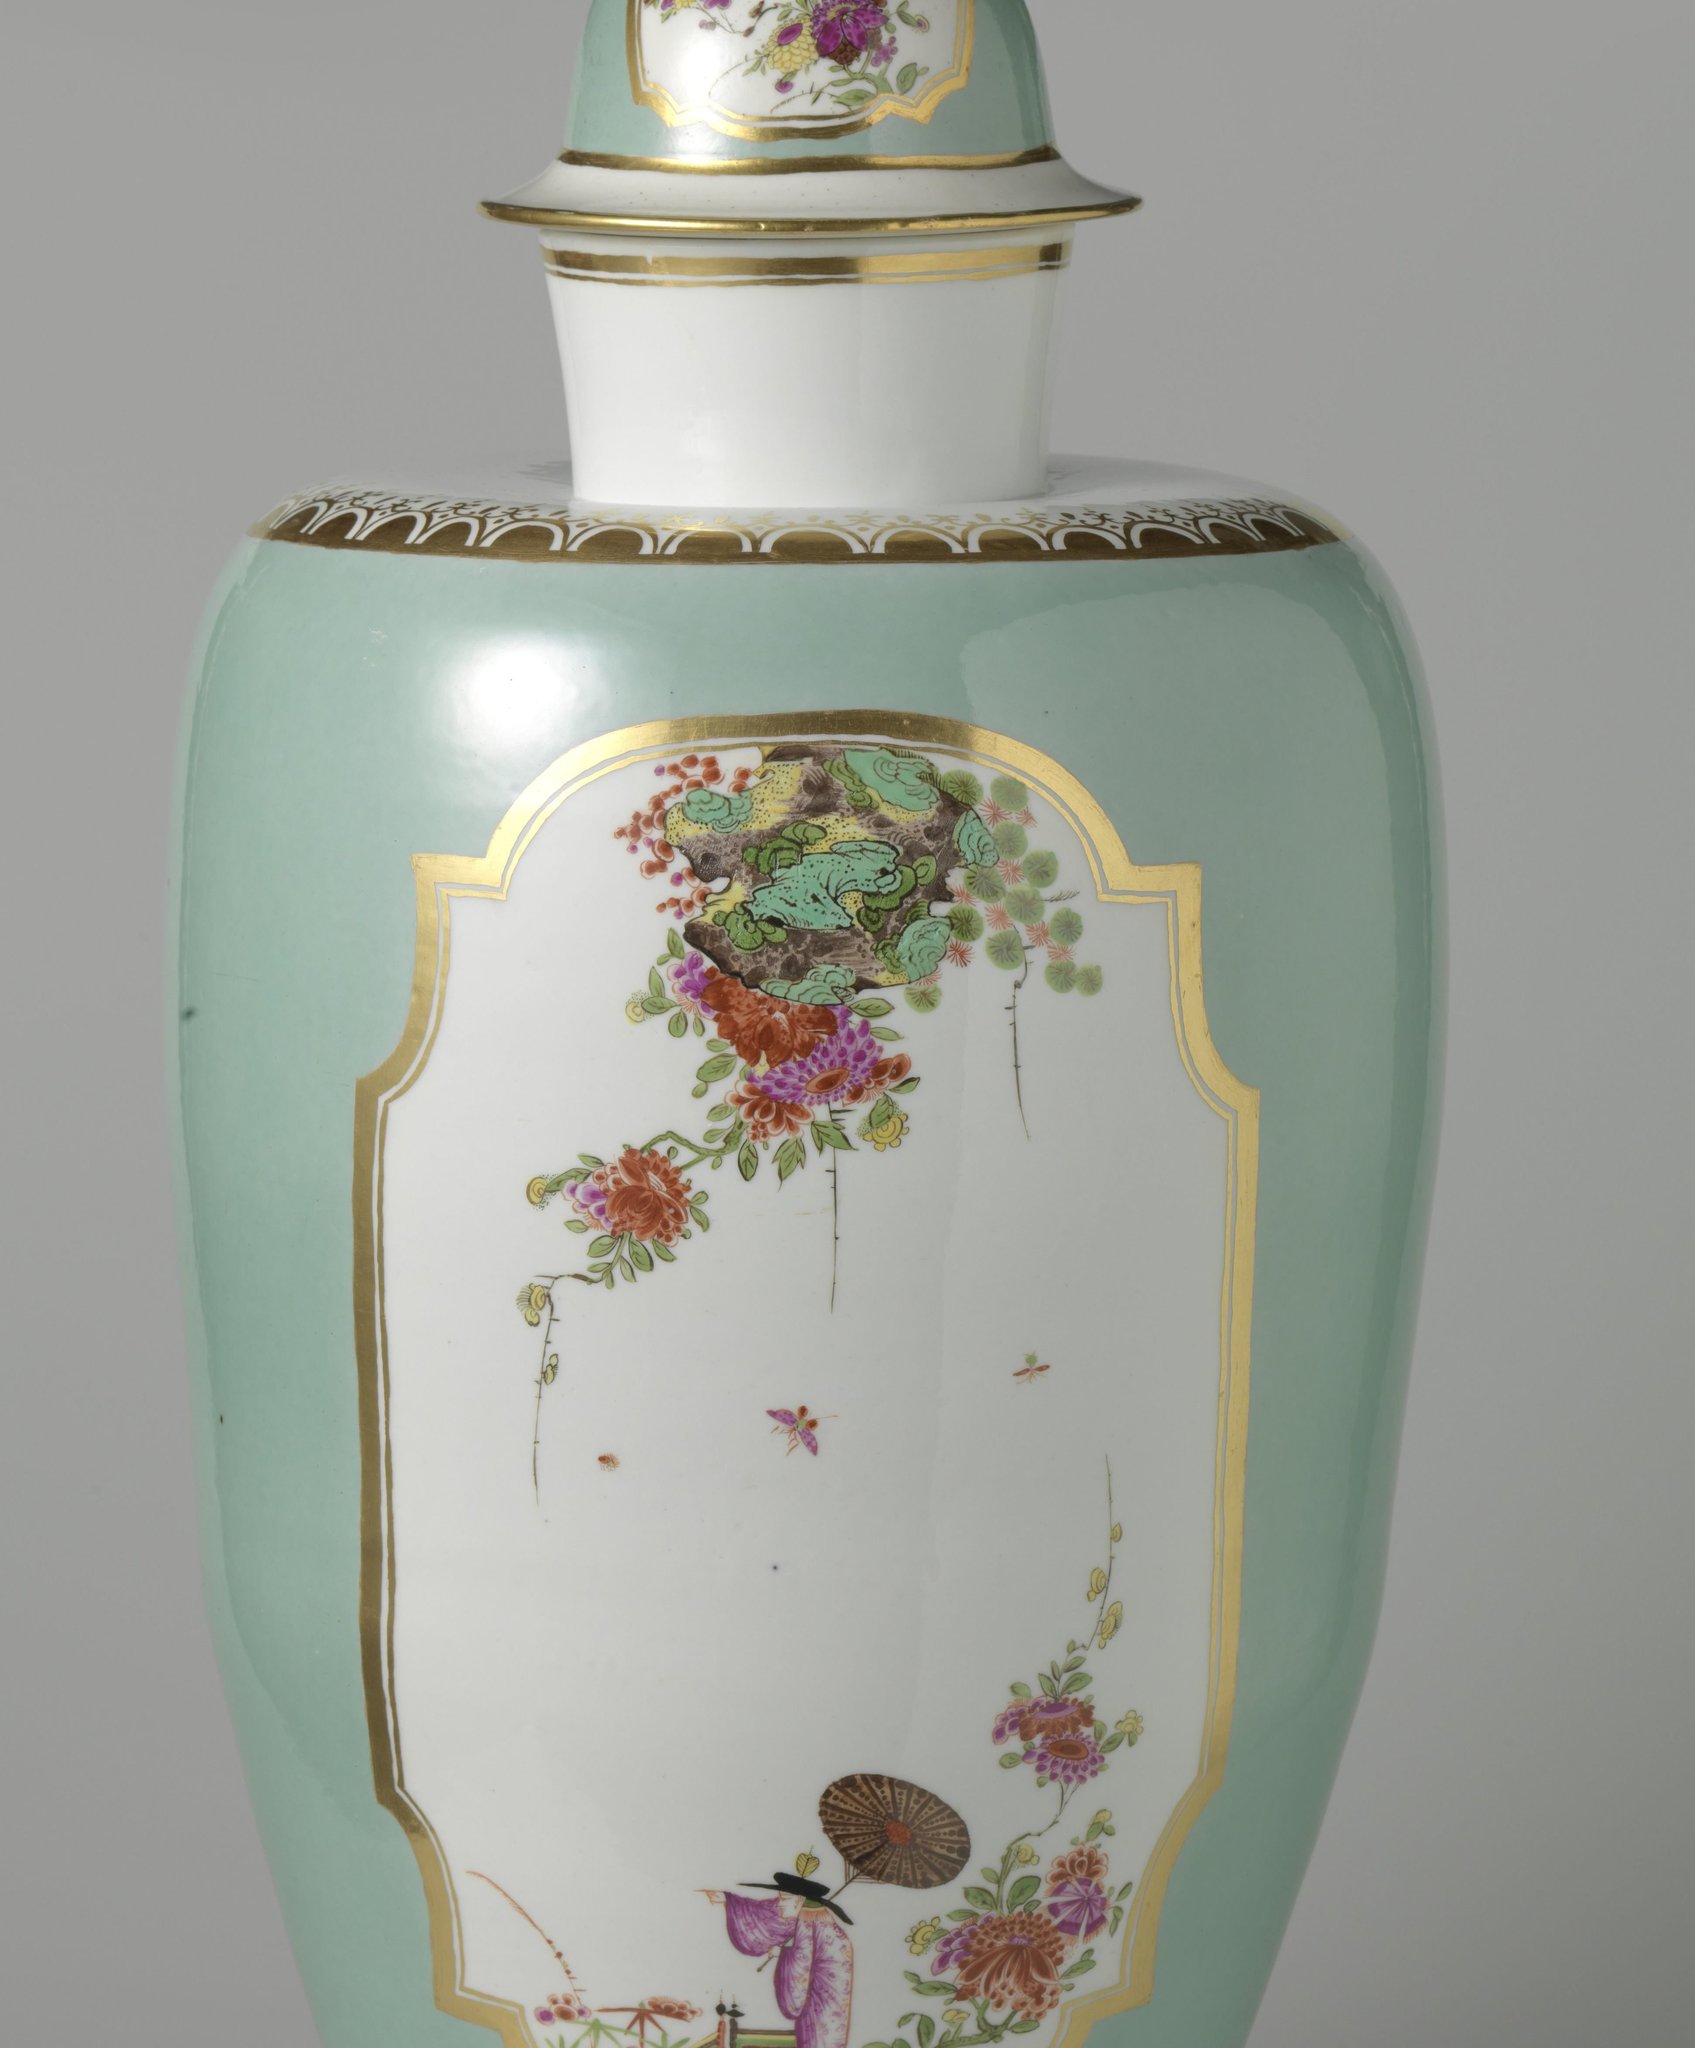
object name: decoratief object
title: Lidded vase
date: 1725-1730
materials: porcelain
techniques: painted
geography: meissen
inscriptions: factory mark: ‘AR’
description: Meissener Porzellan Manufaktur Meissen, c. 1725–1730 hard-paste porcelain